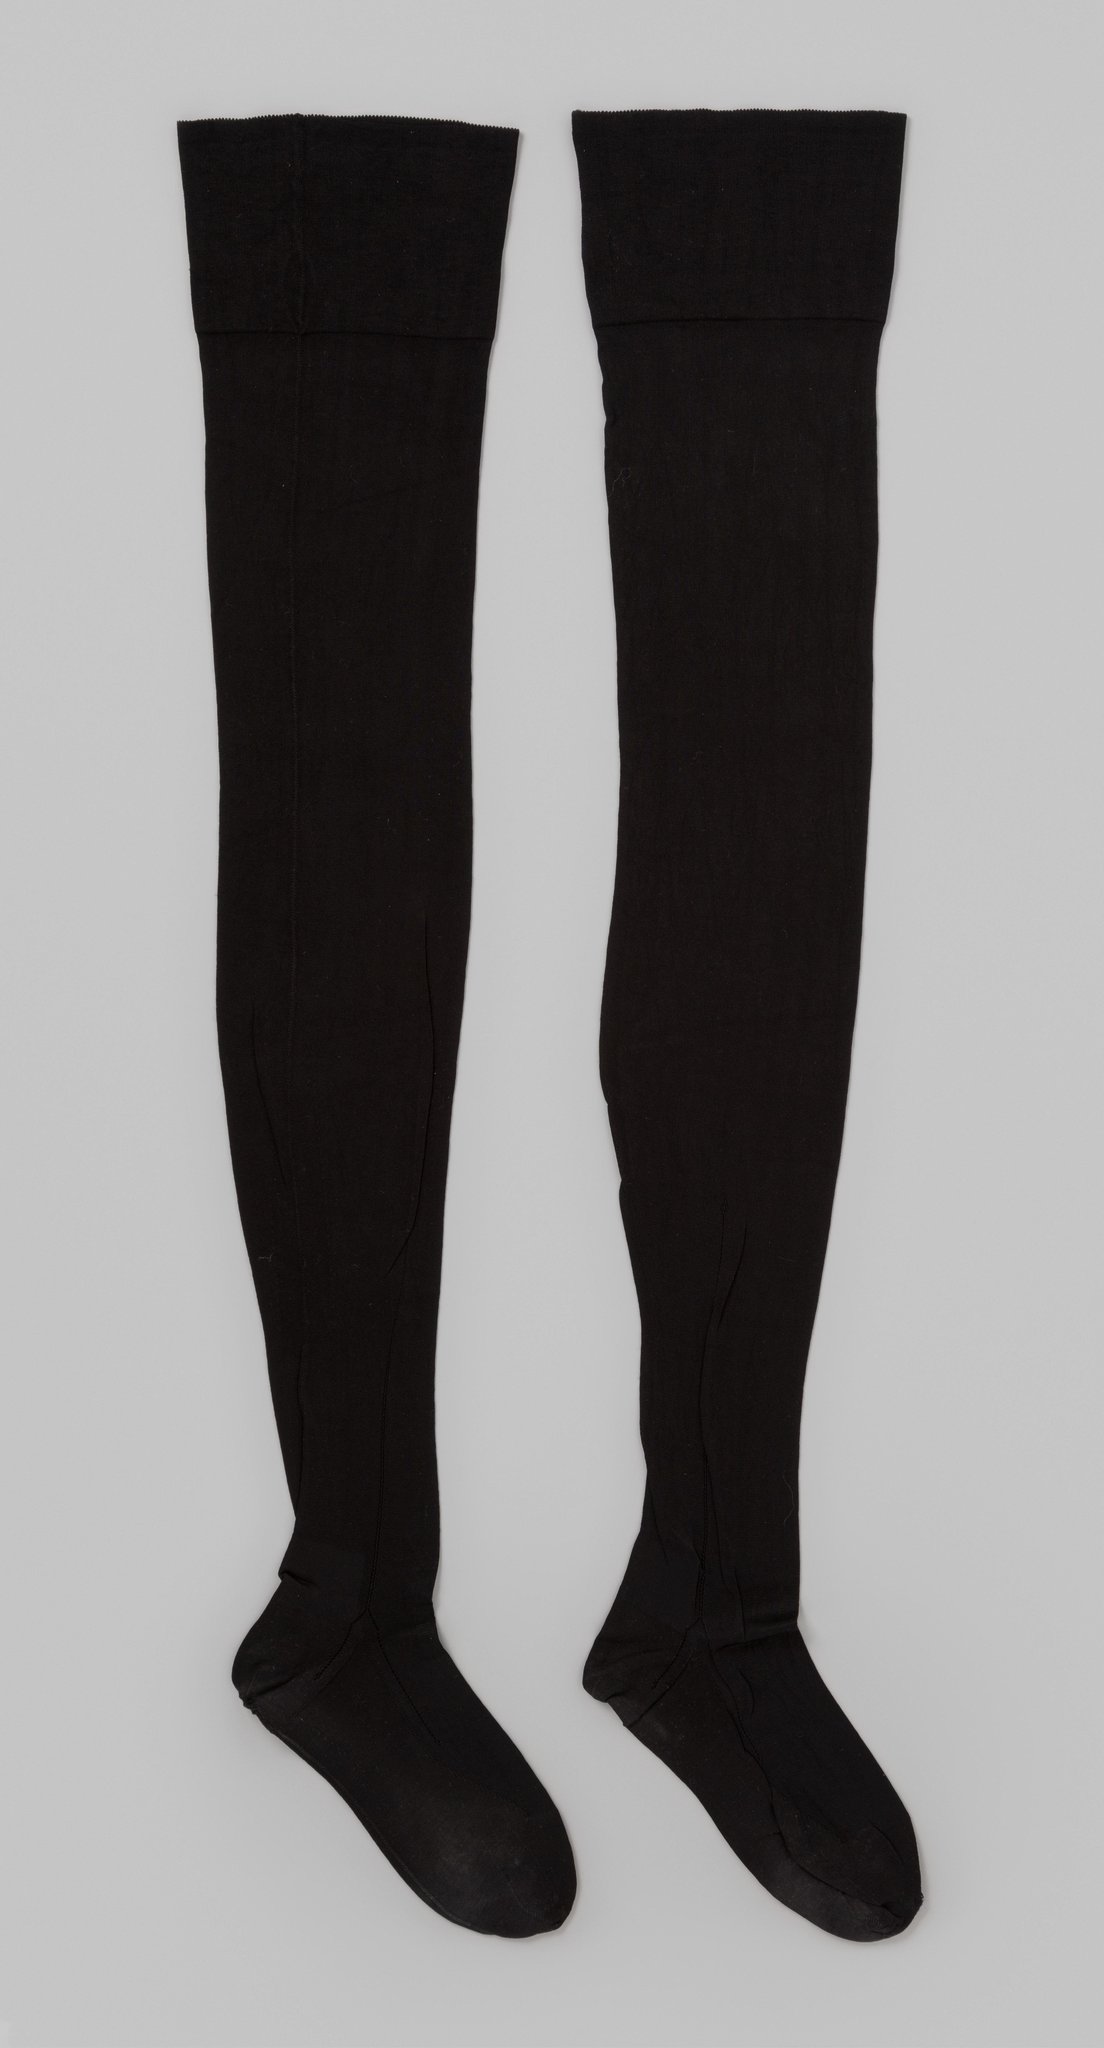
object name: stocking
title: Kous van effen zwarte zijden tricot met smalle verticale lijn op de klink en brede boord met kleine kartels langs de rand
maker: Anonymous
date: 1915-1935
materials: silk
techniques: knitting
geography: netherlands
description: Vijf paar zwarte kousen van zijde. Alle verschillend, alle van dikke tricot. Alle met naad en hiel. Brede verschillende boorden; enkele van katoen. Eén paar heeft een enkel-pijl, de klink.